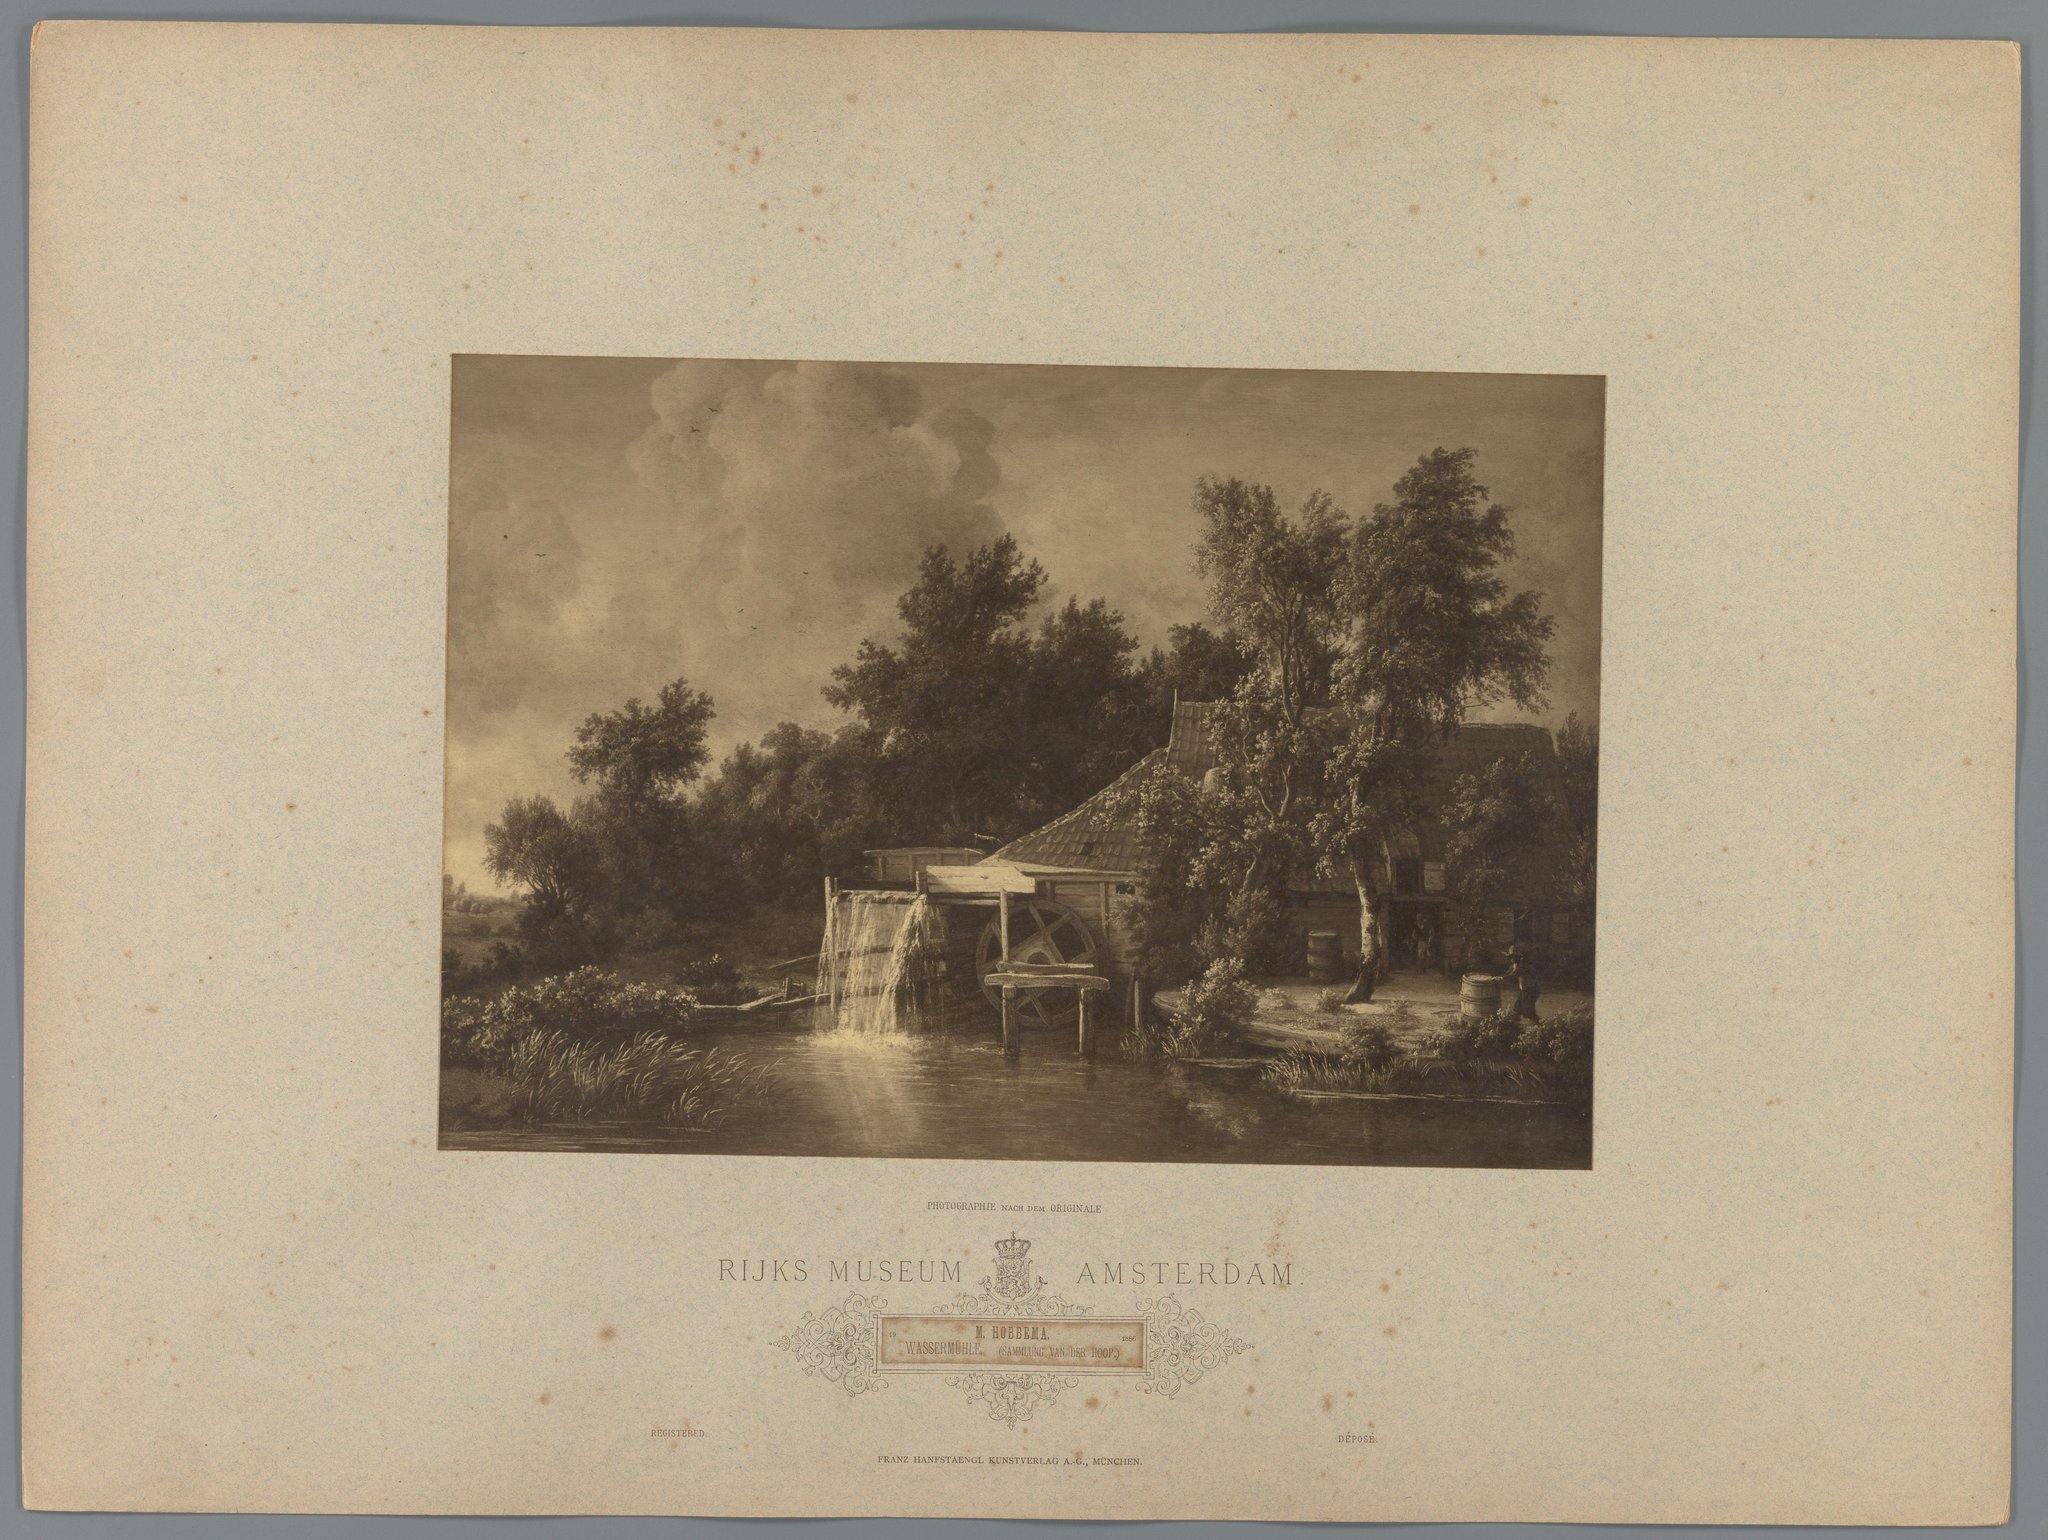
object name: photograph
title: Fotoreproductie van het schilderij Een watermolen door Meindert Hobbema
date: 1886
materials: cardboard, paper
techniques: carbon print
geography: munich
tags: watermill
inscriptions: number: ‘19’, inscription: ‘Photographie nach dem Originale/ Rijks Museum Amsterdam/ Registered. Déposé.’